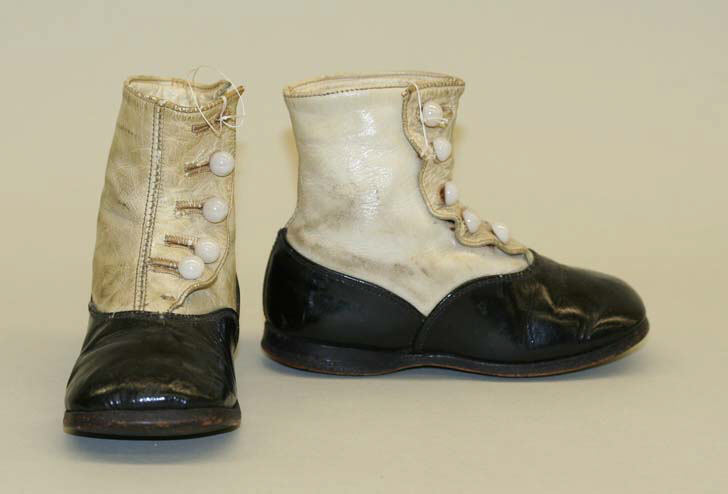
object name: boot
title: Boots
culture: american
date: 1900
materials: leather